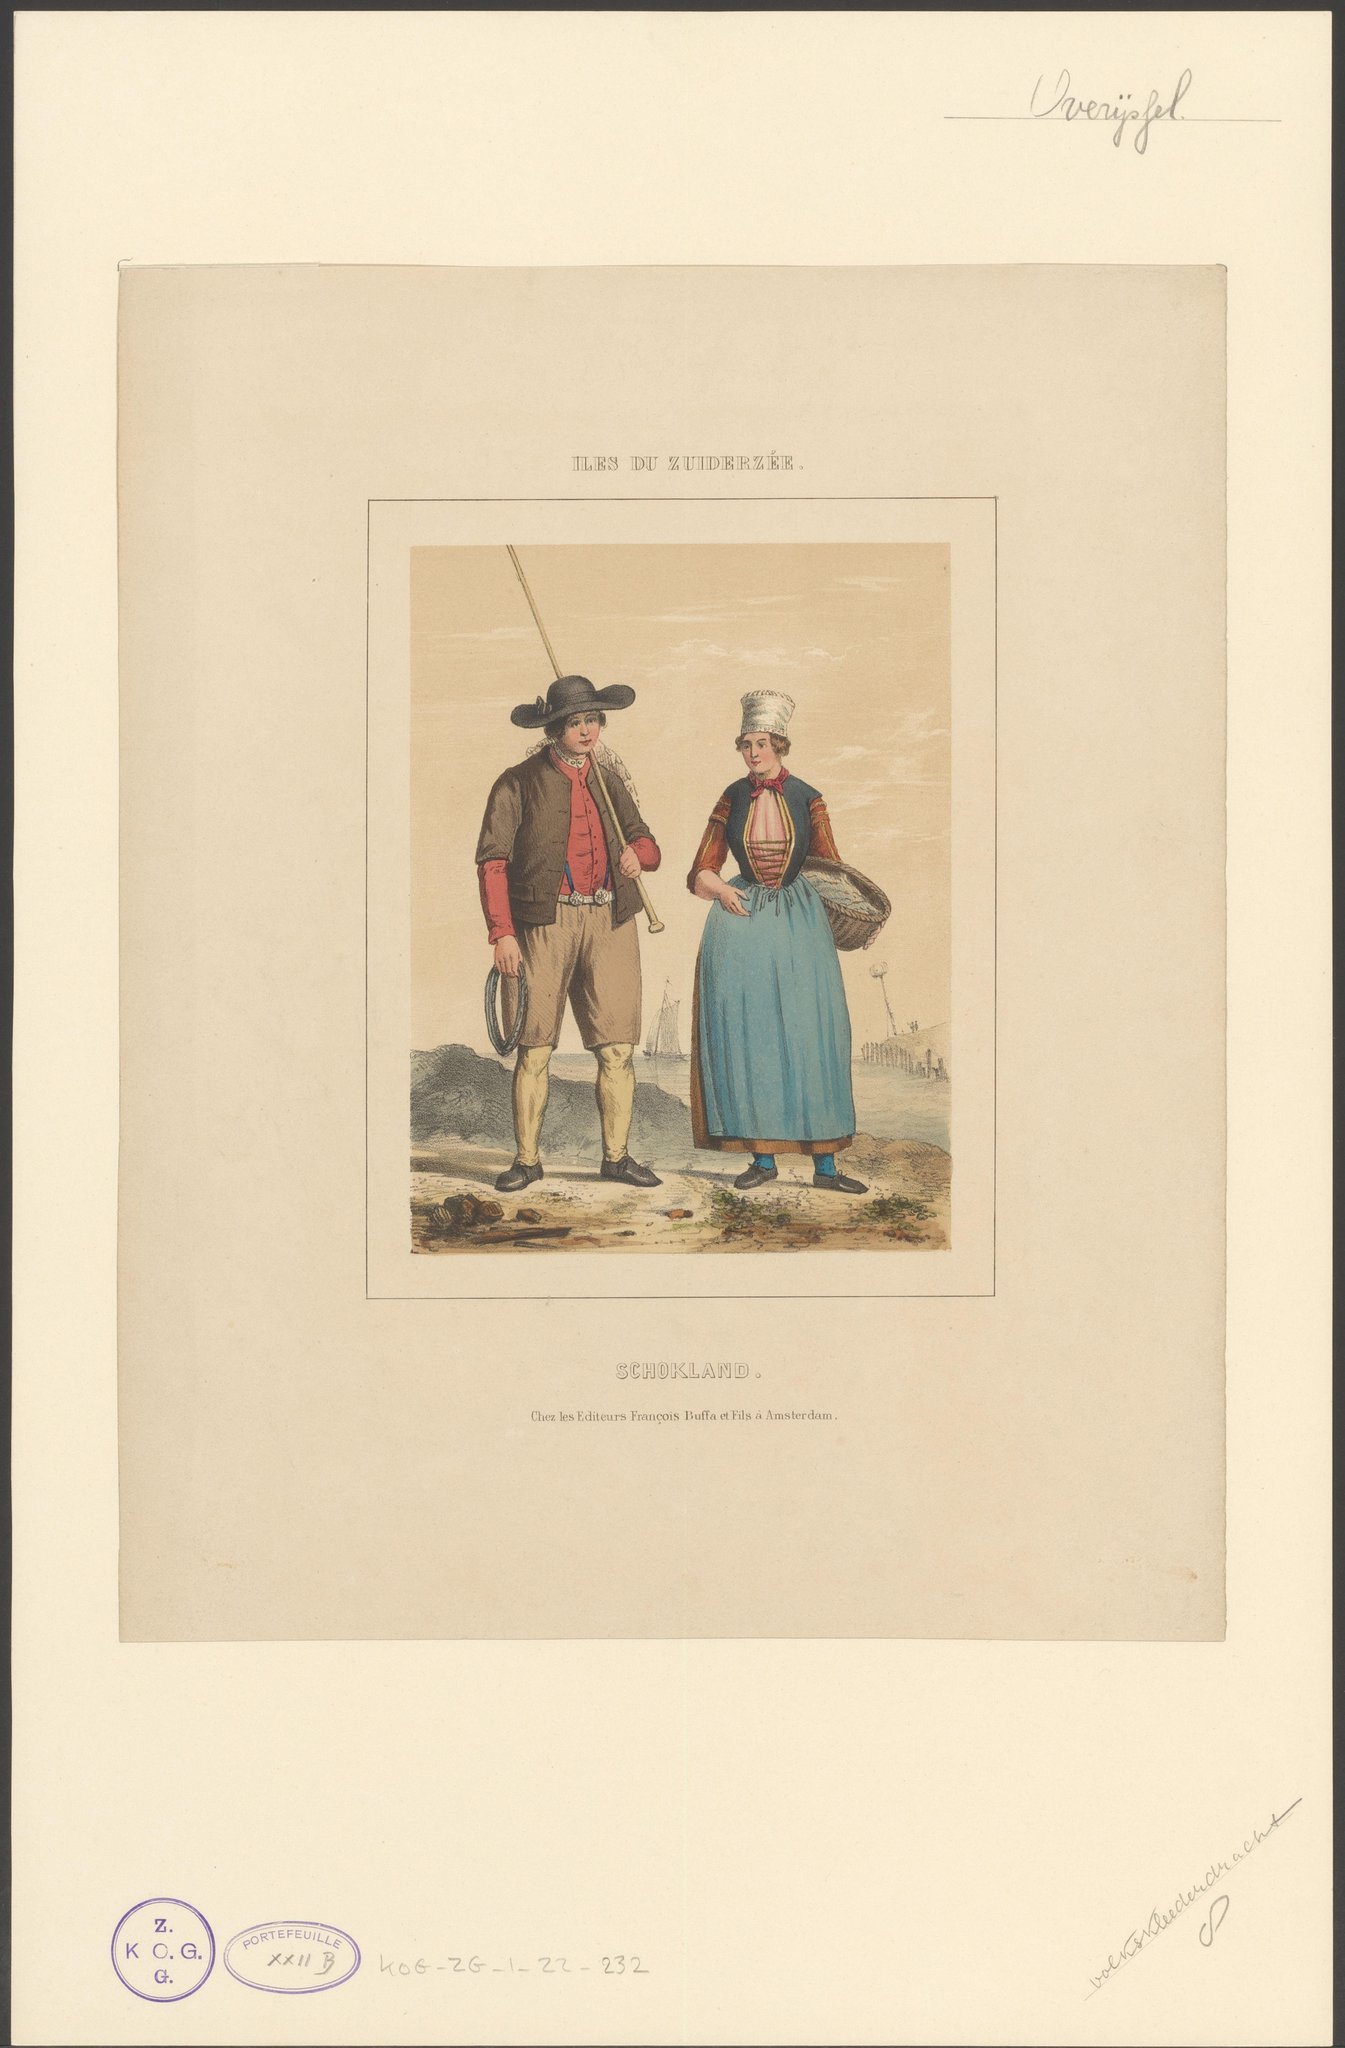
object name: print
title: Iles de Zuiderzée / Scholkand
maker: Anonymous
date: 1836-1880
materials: paper, watercolor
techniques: hand coloring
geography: netherlands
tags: sea and coastal fishery (+ men (labourers)), sea and coastal fishery (+ women (labourers)), clothes, costume (+ women's clothes), clothes, costume (+ men's clothes), folk costume, regional costume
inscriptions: collector's mark: Lugt 1641, collector's mark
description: Man en vrouw van Schokland, vissers. Onderwerpsrubrieken binnen de Atlas Zeden en Gewoonten: De Kleeding, Volkskleederdracht, Overijssel.